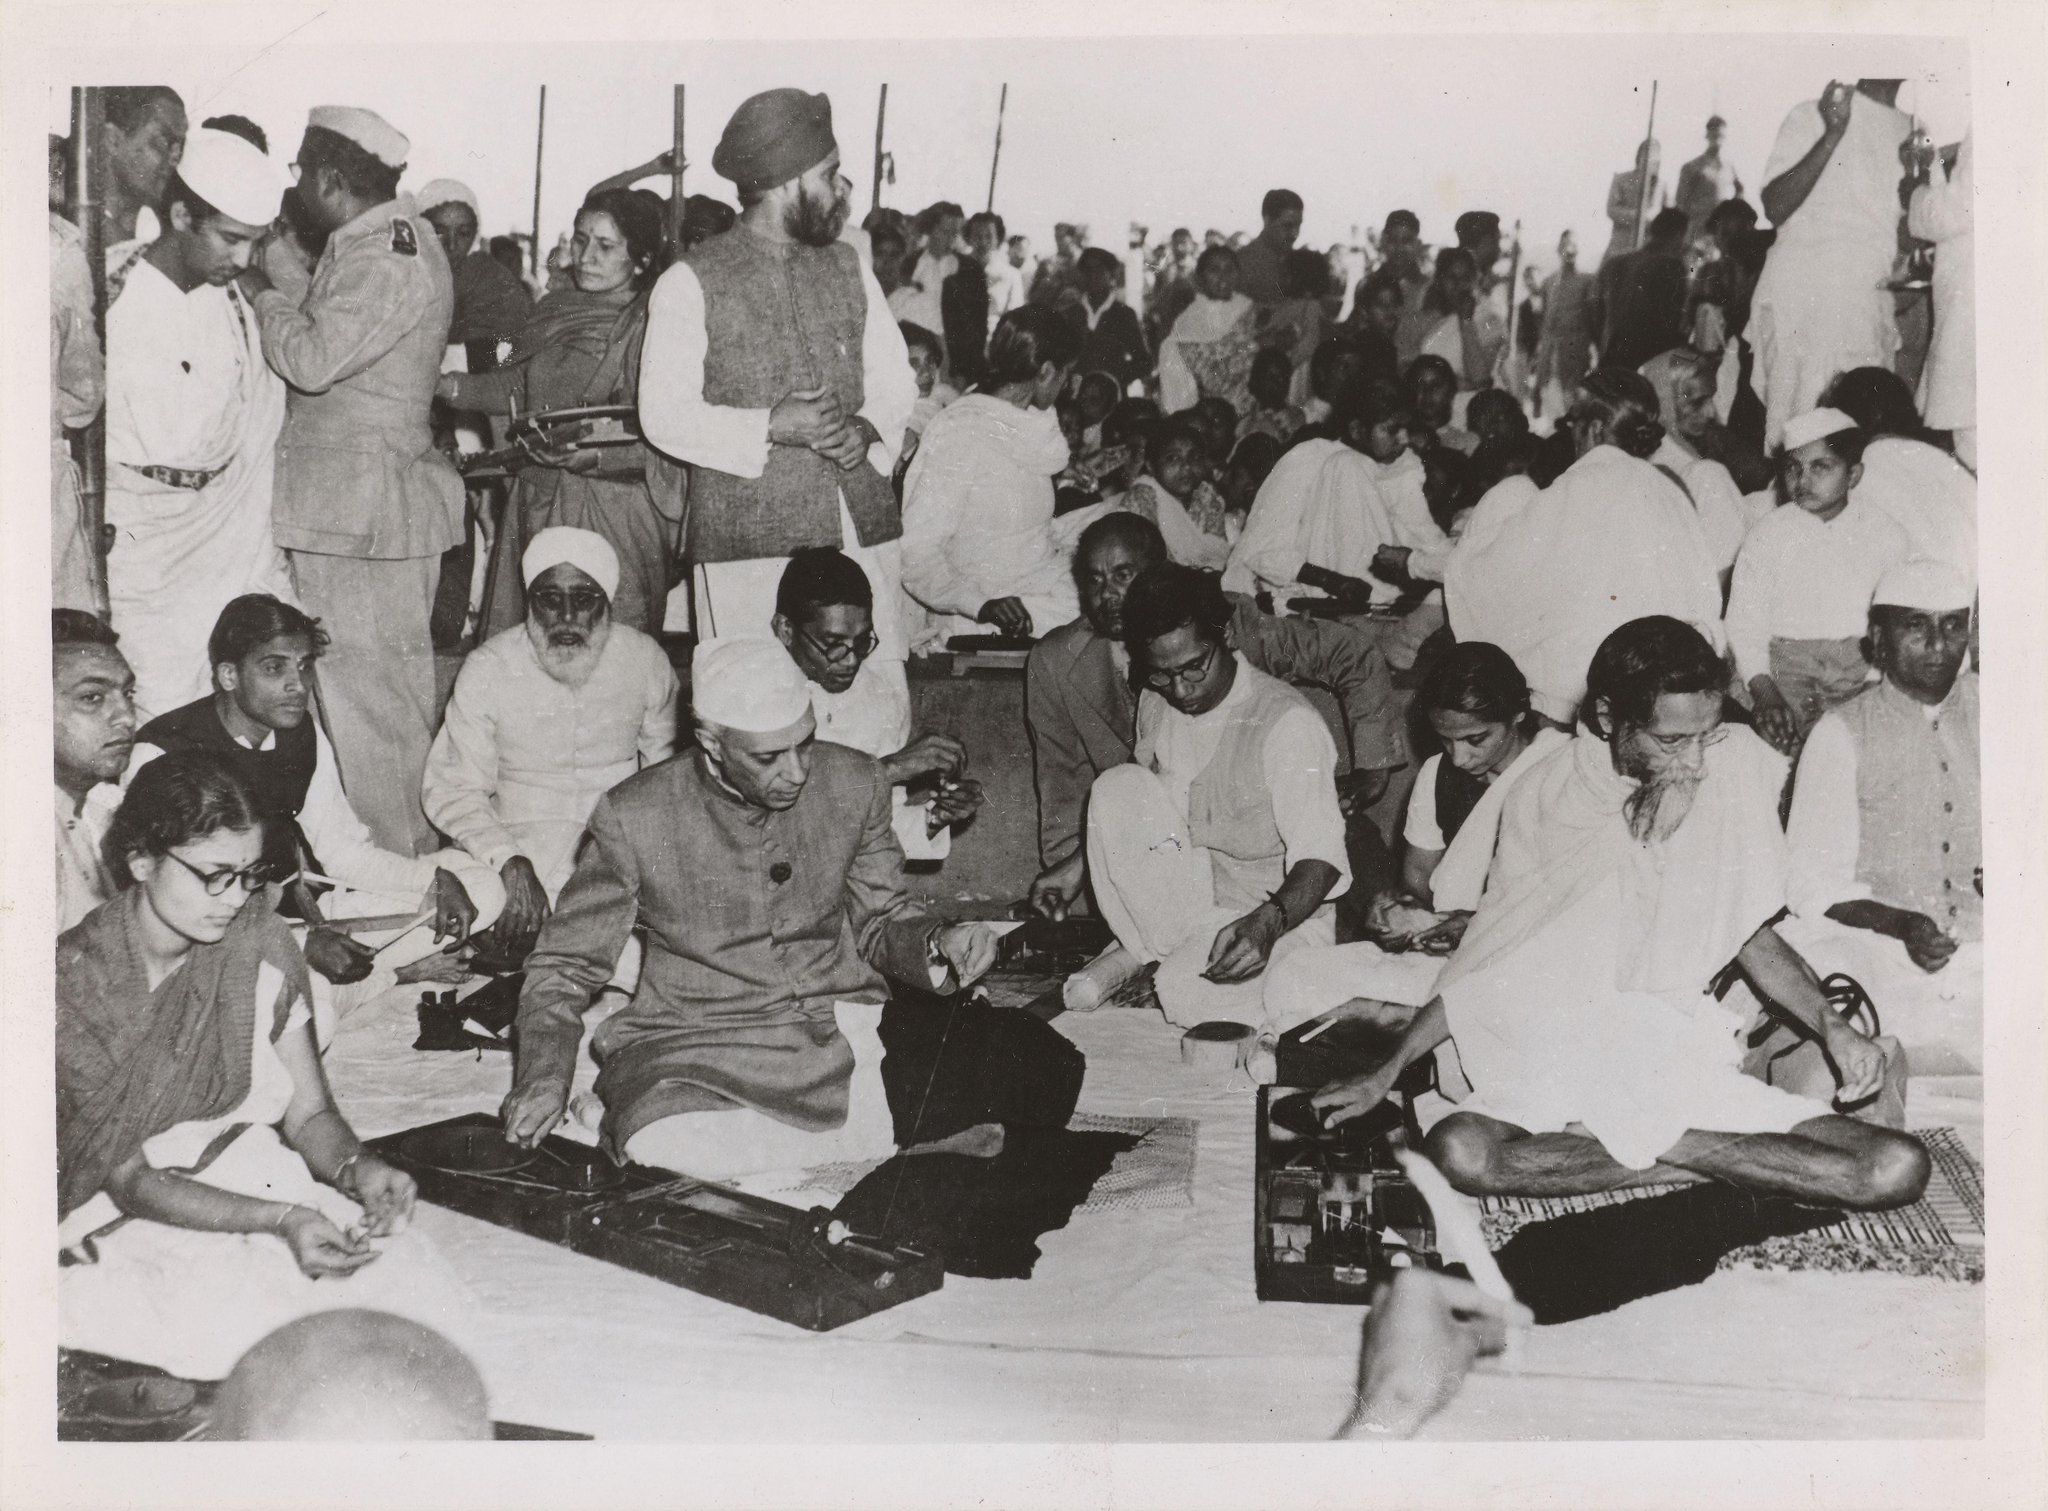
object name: photograph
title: Nehru op viering eerste sterfjaar Gandhi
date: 1949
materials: photographic support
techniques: gelatin silver print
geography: london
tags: politician